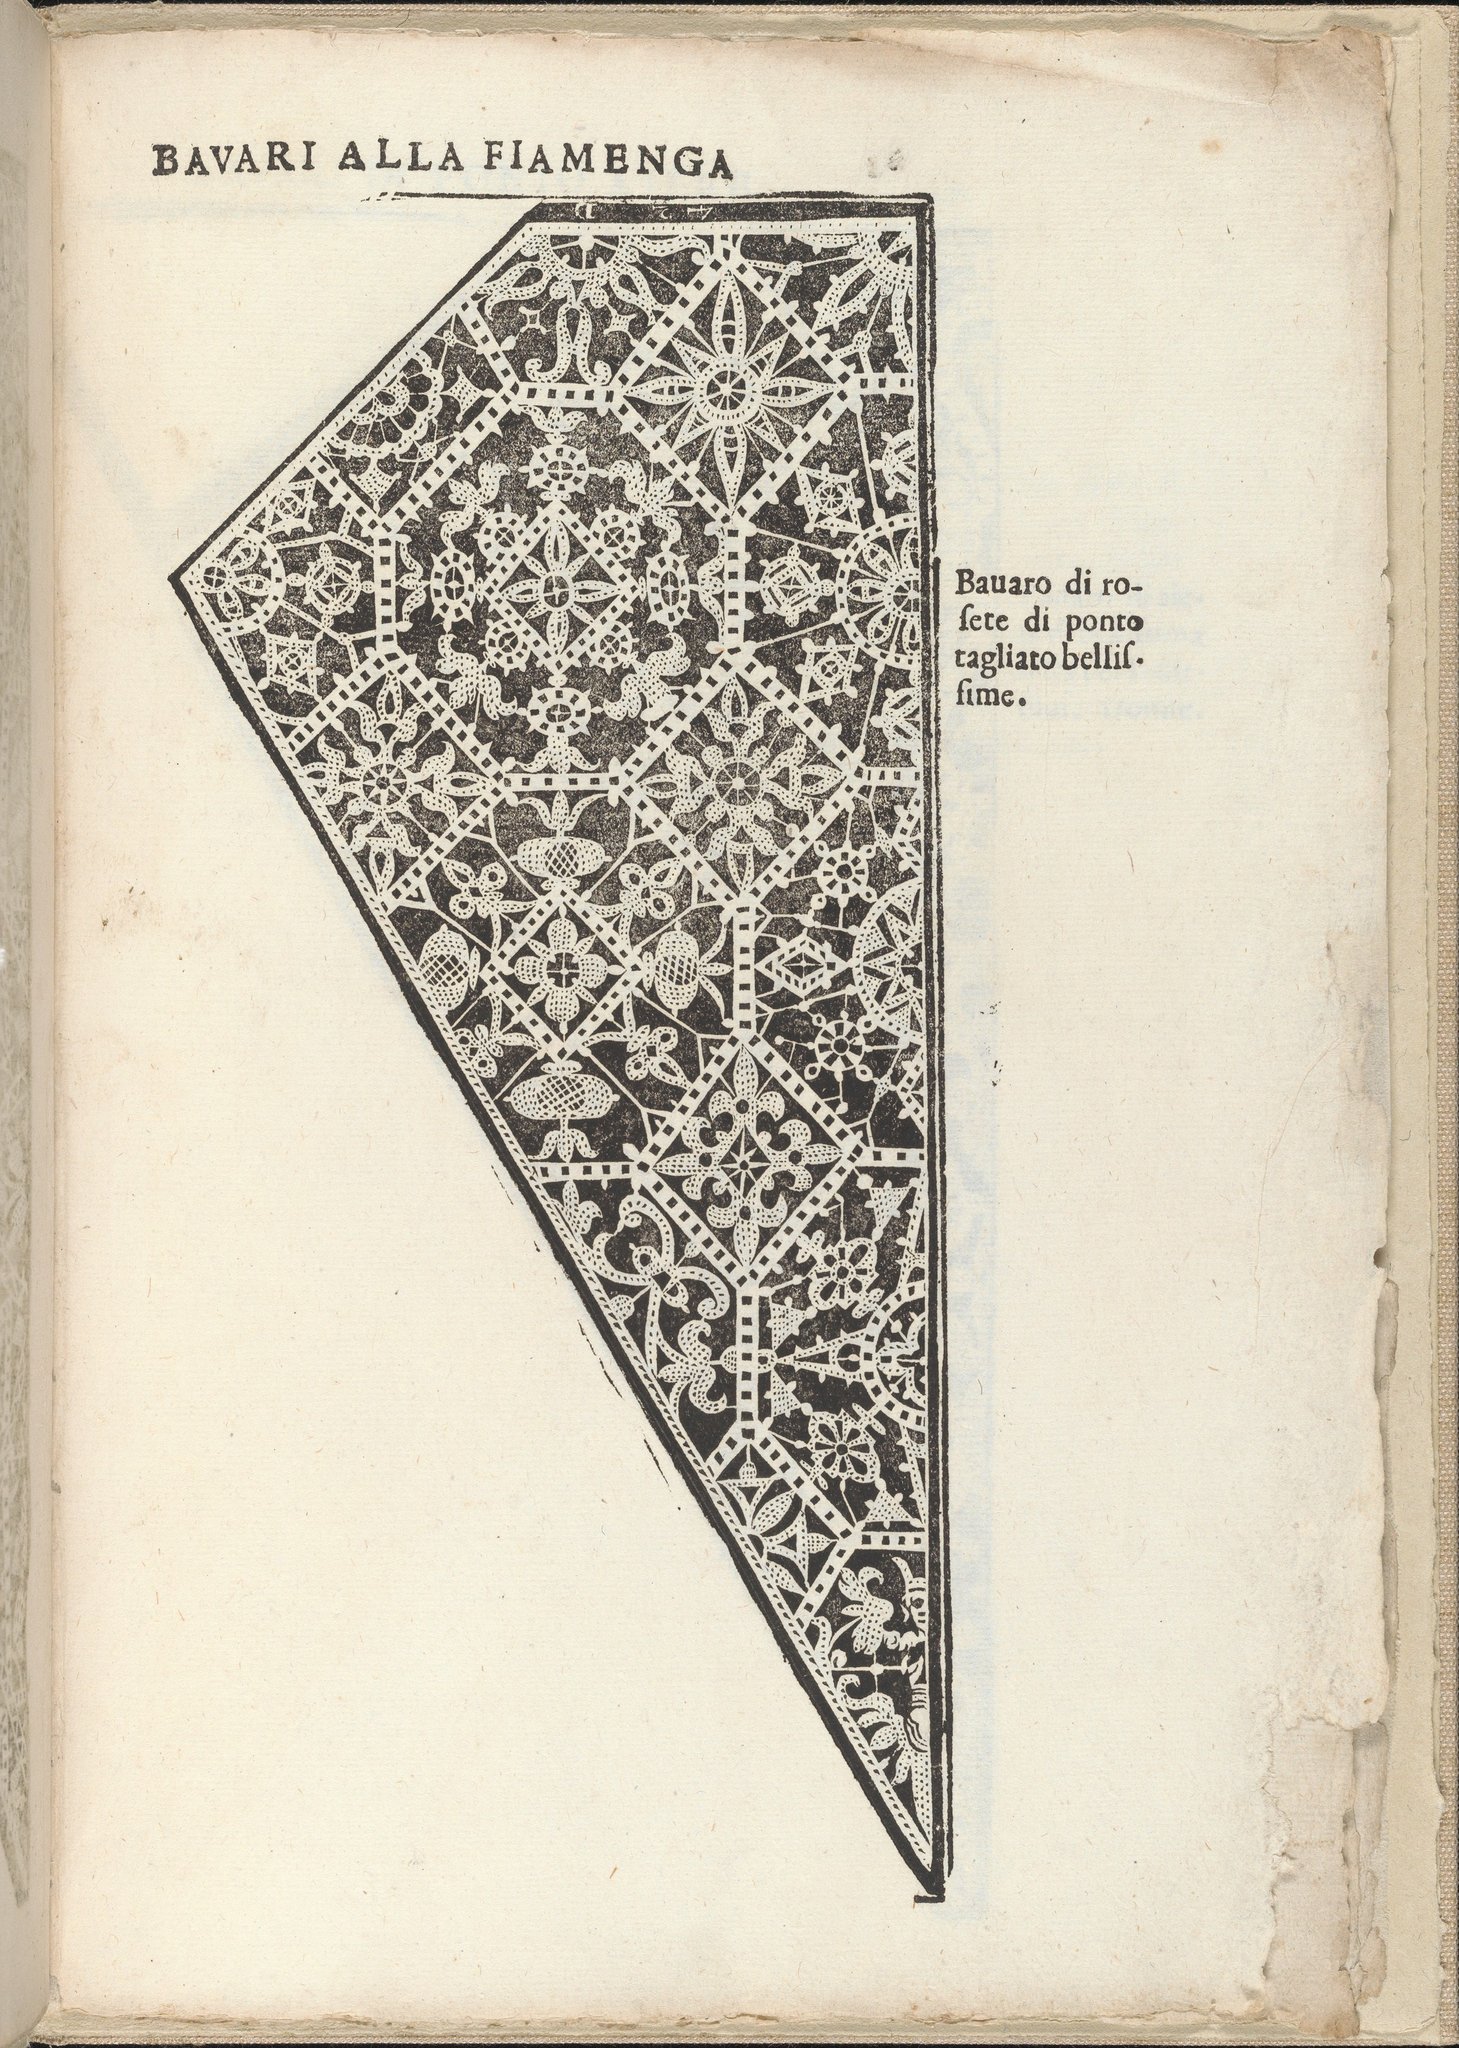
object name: book print ornament architecture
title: Ornamento nobile...Fatta da Lucretia Romana (Libro V of the Corona), page 12 (recto)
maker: cesare vecellio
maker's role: author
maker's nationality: italian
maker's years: 1521-1601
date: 1620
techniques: woodcut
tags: ornament